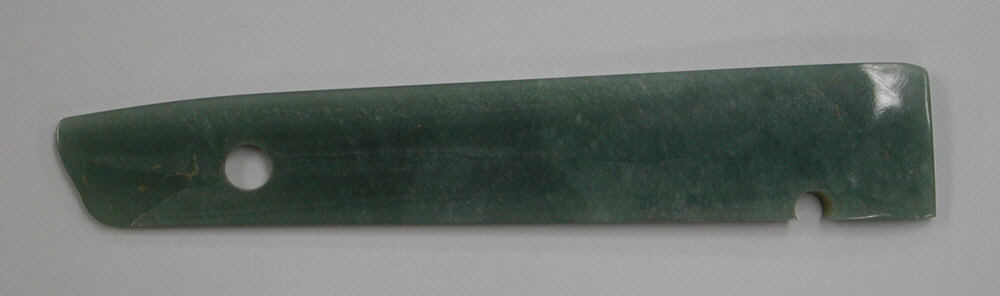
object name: celt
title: Reworked Olmec celt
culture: costa rican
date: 200 BCE-500 CE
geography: costa rica